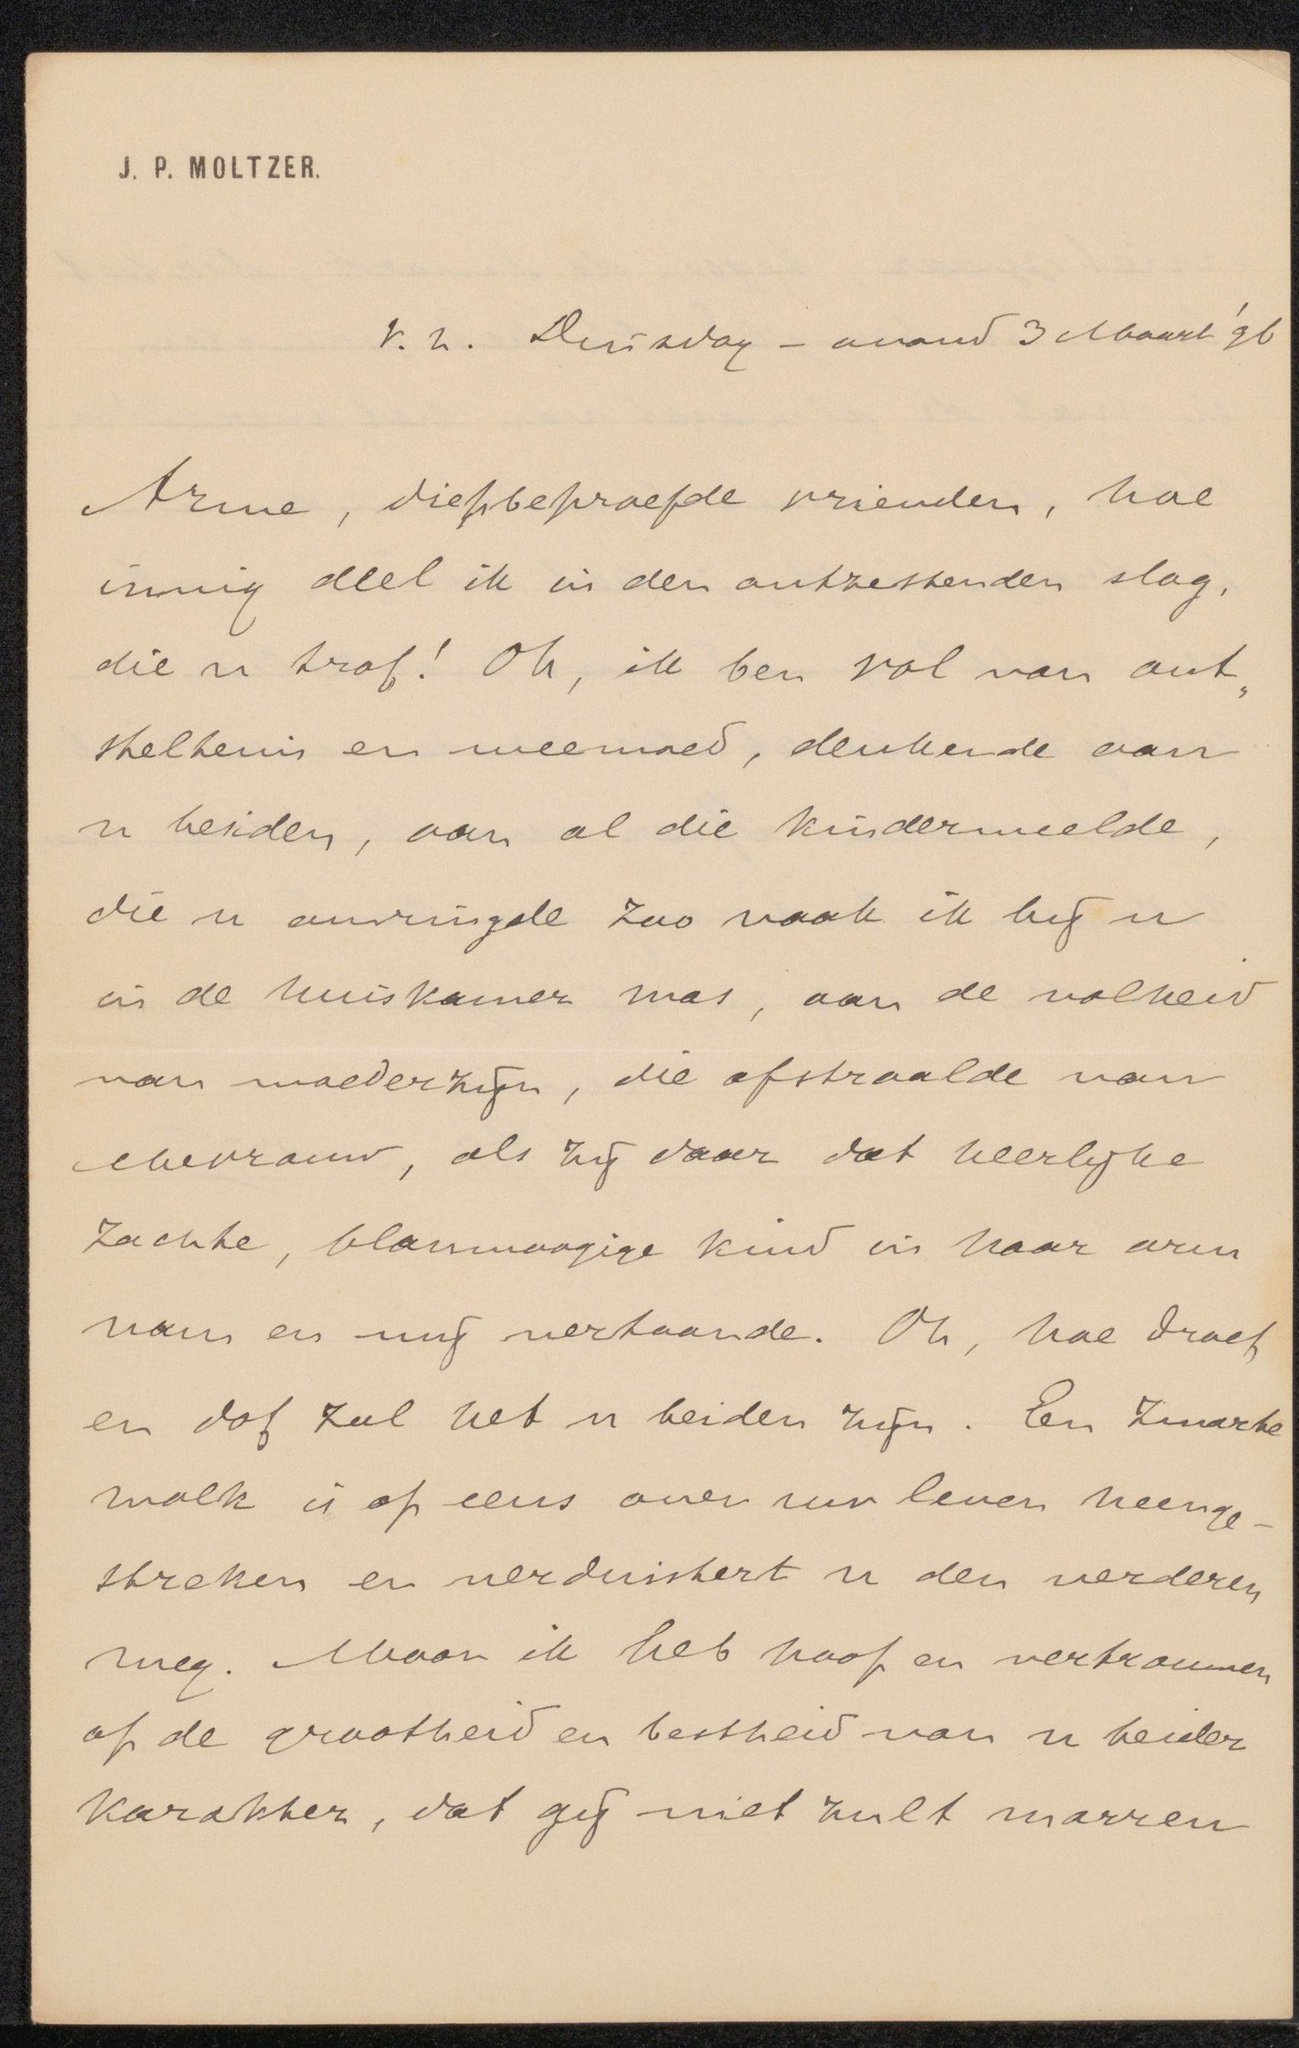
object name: letter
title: Brief aan Jan Veth en Anna Dorothea Dirks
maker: jacob pieter moltzer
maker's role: jurist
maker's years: 1850-1907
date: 1896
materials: ink, paper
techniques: pen, writing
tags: dordrecht, painter, print maker, draughtsman, designer, jan veth, artist, anna dorothea dirks, passions, emotions, affections, family life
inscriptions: collector's mark: ‘RPK’, name: ‘J.P.MOLTZER.’